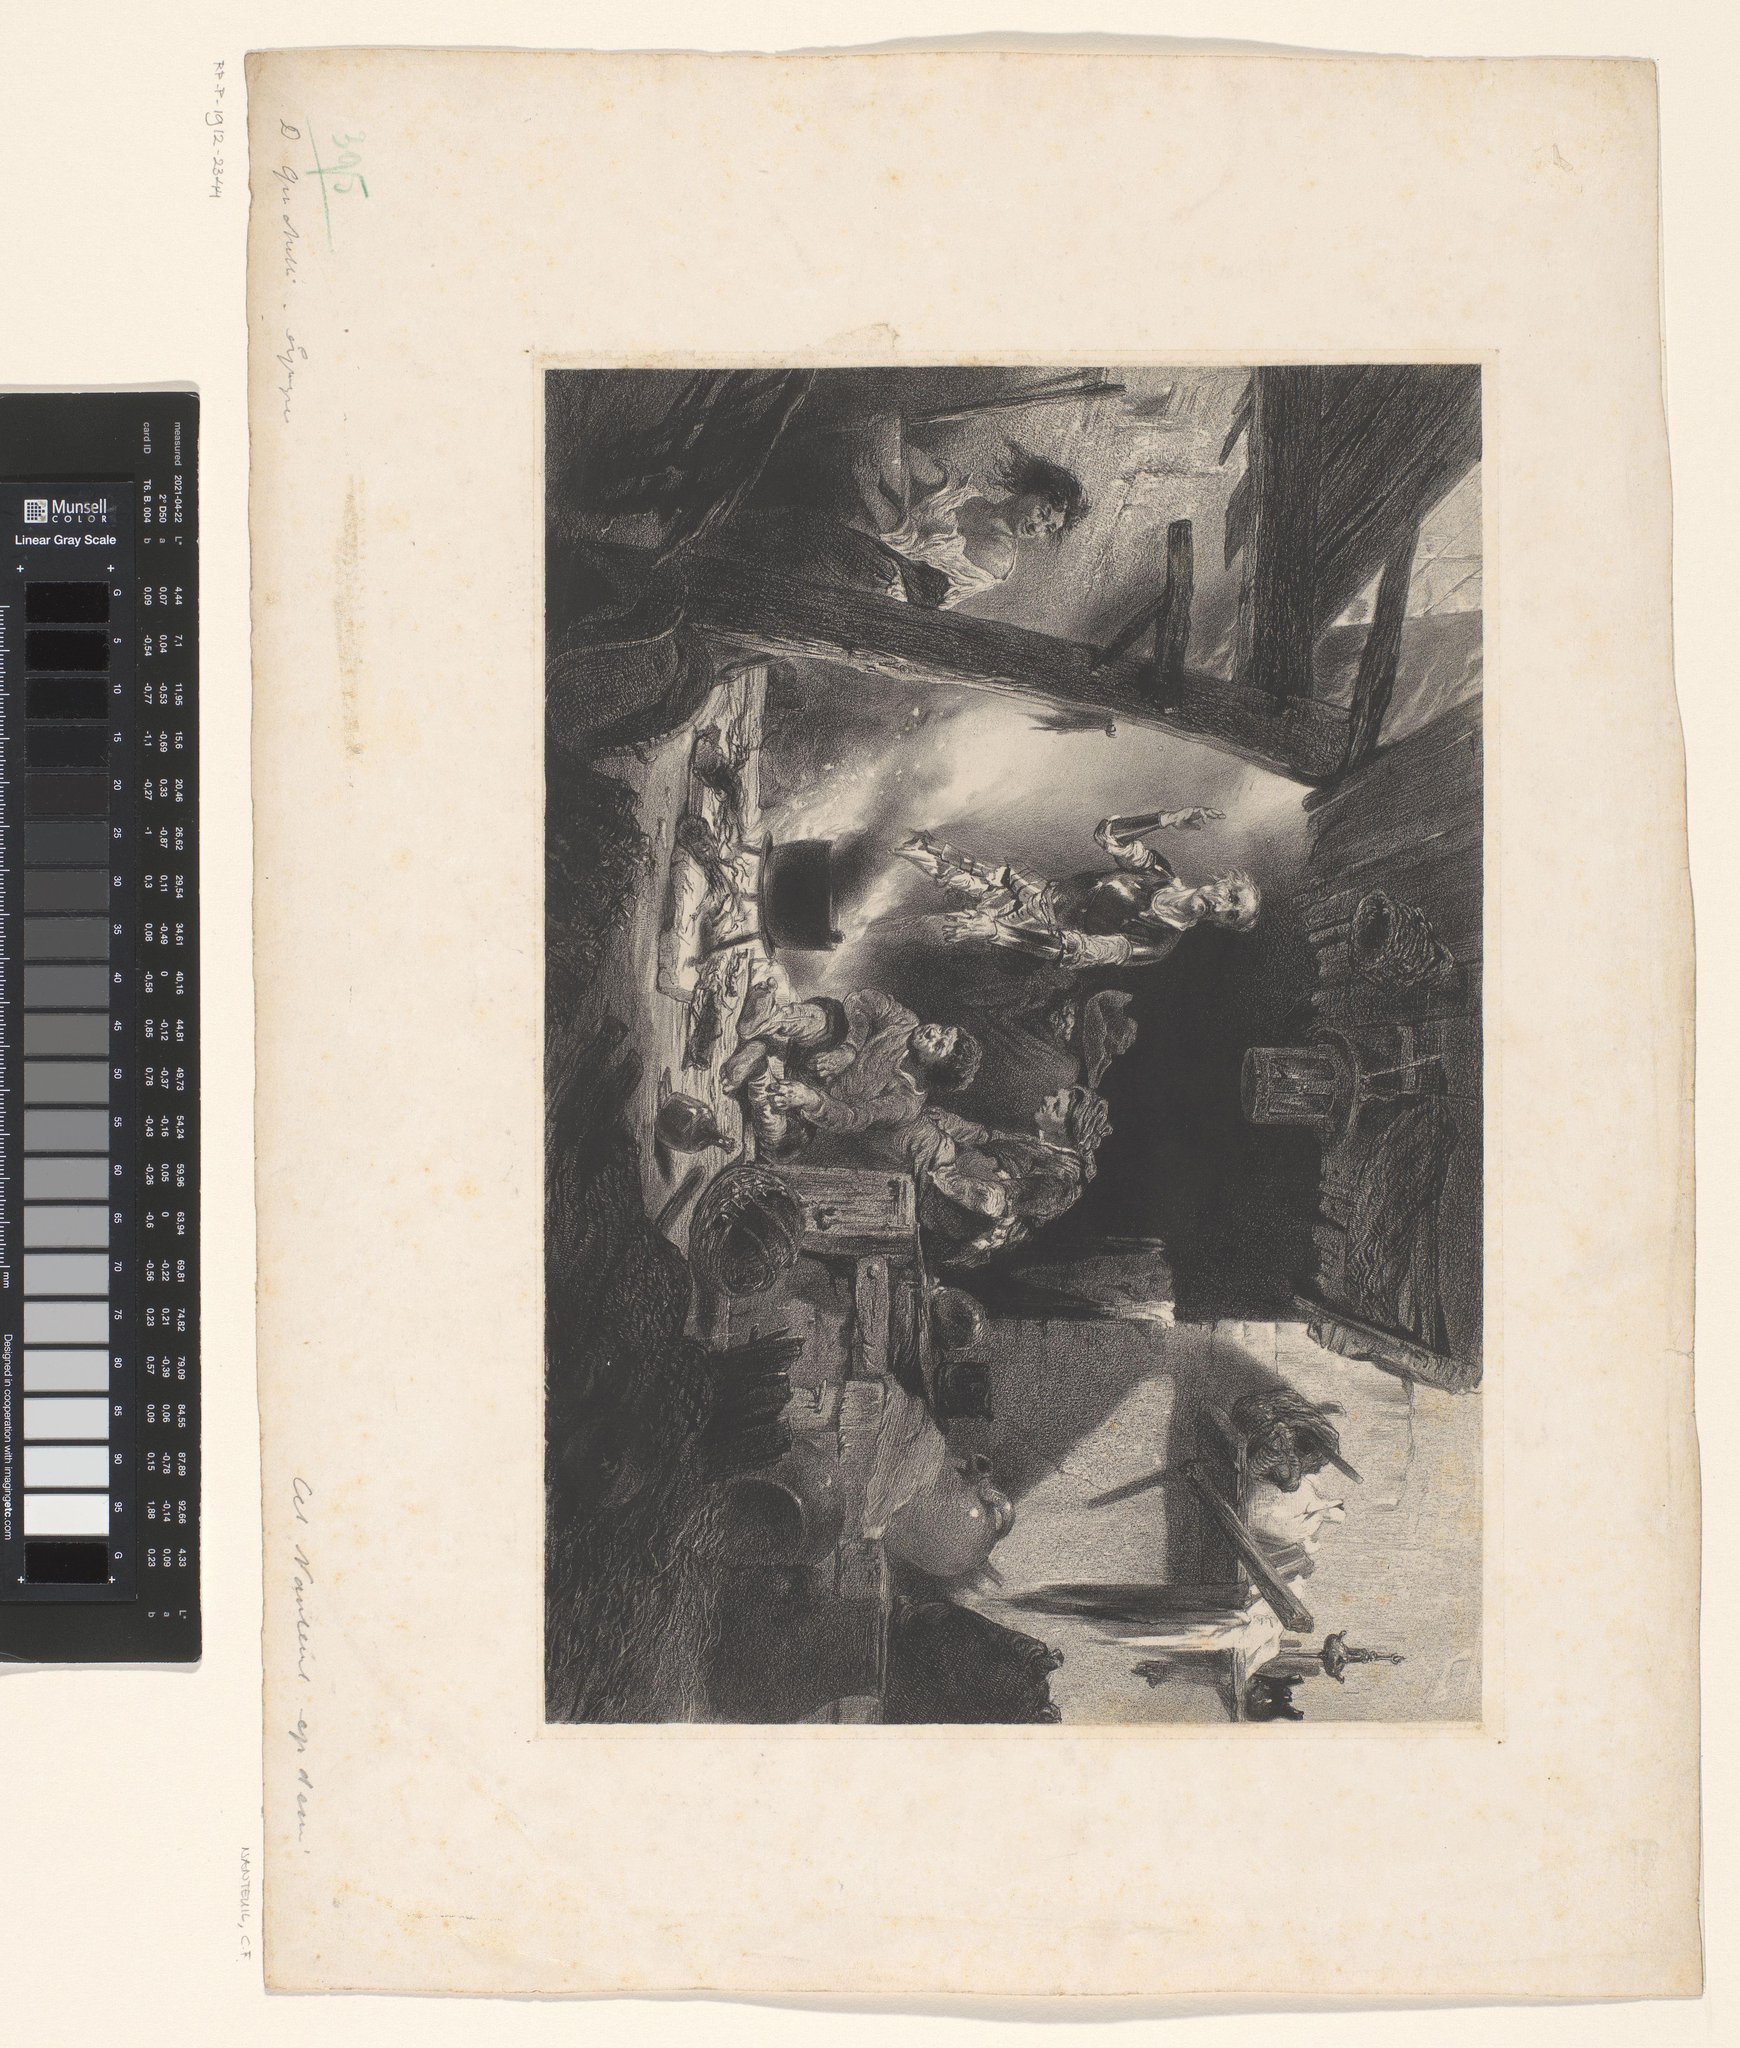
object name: print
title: Don Quichot in een herberg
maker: célestin françois nanteuil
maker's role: print maker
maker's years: 1813-1873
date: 1855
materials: paper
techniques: lithograph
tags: don quixote, hotel, hostelry, inn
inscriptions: collector's mark: Lugt 2228